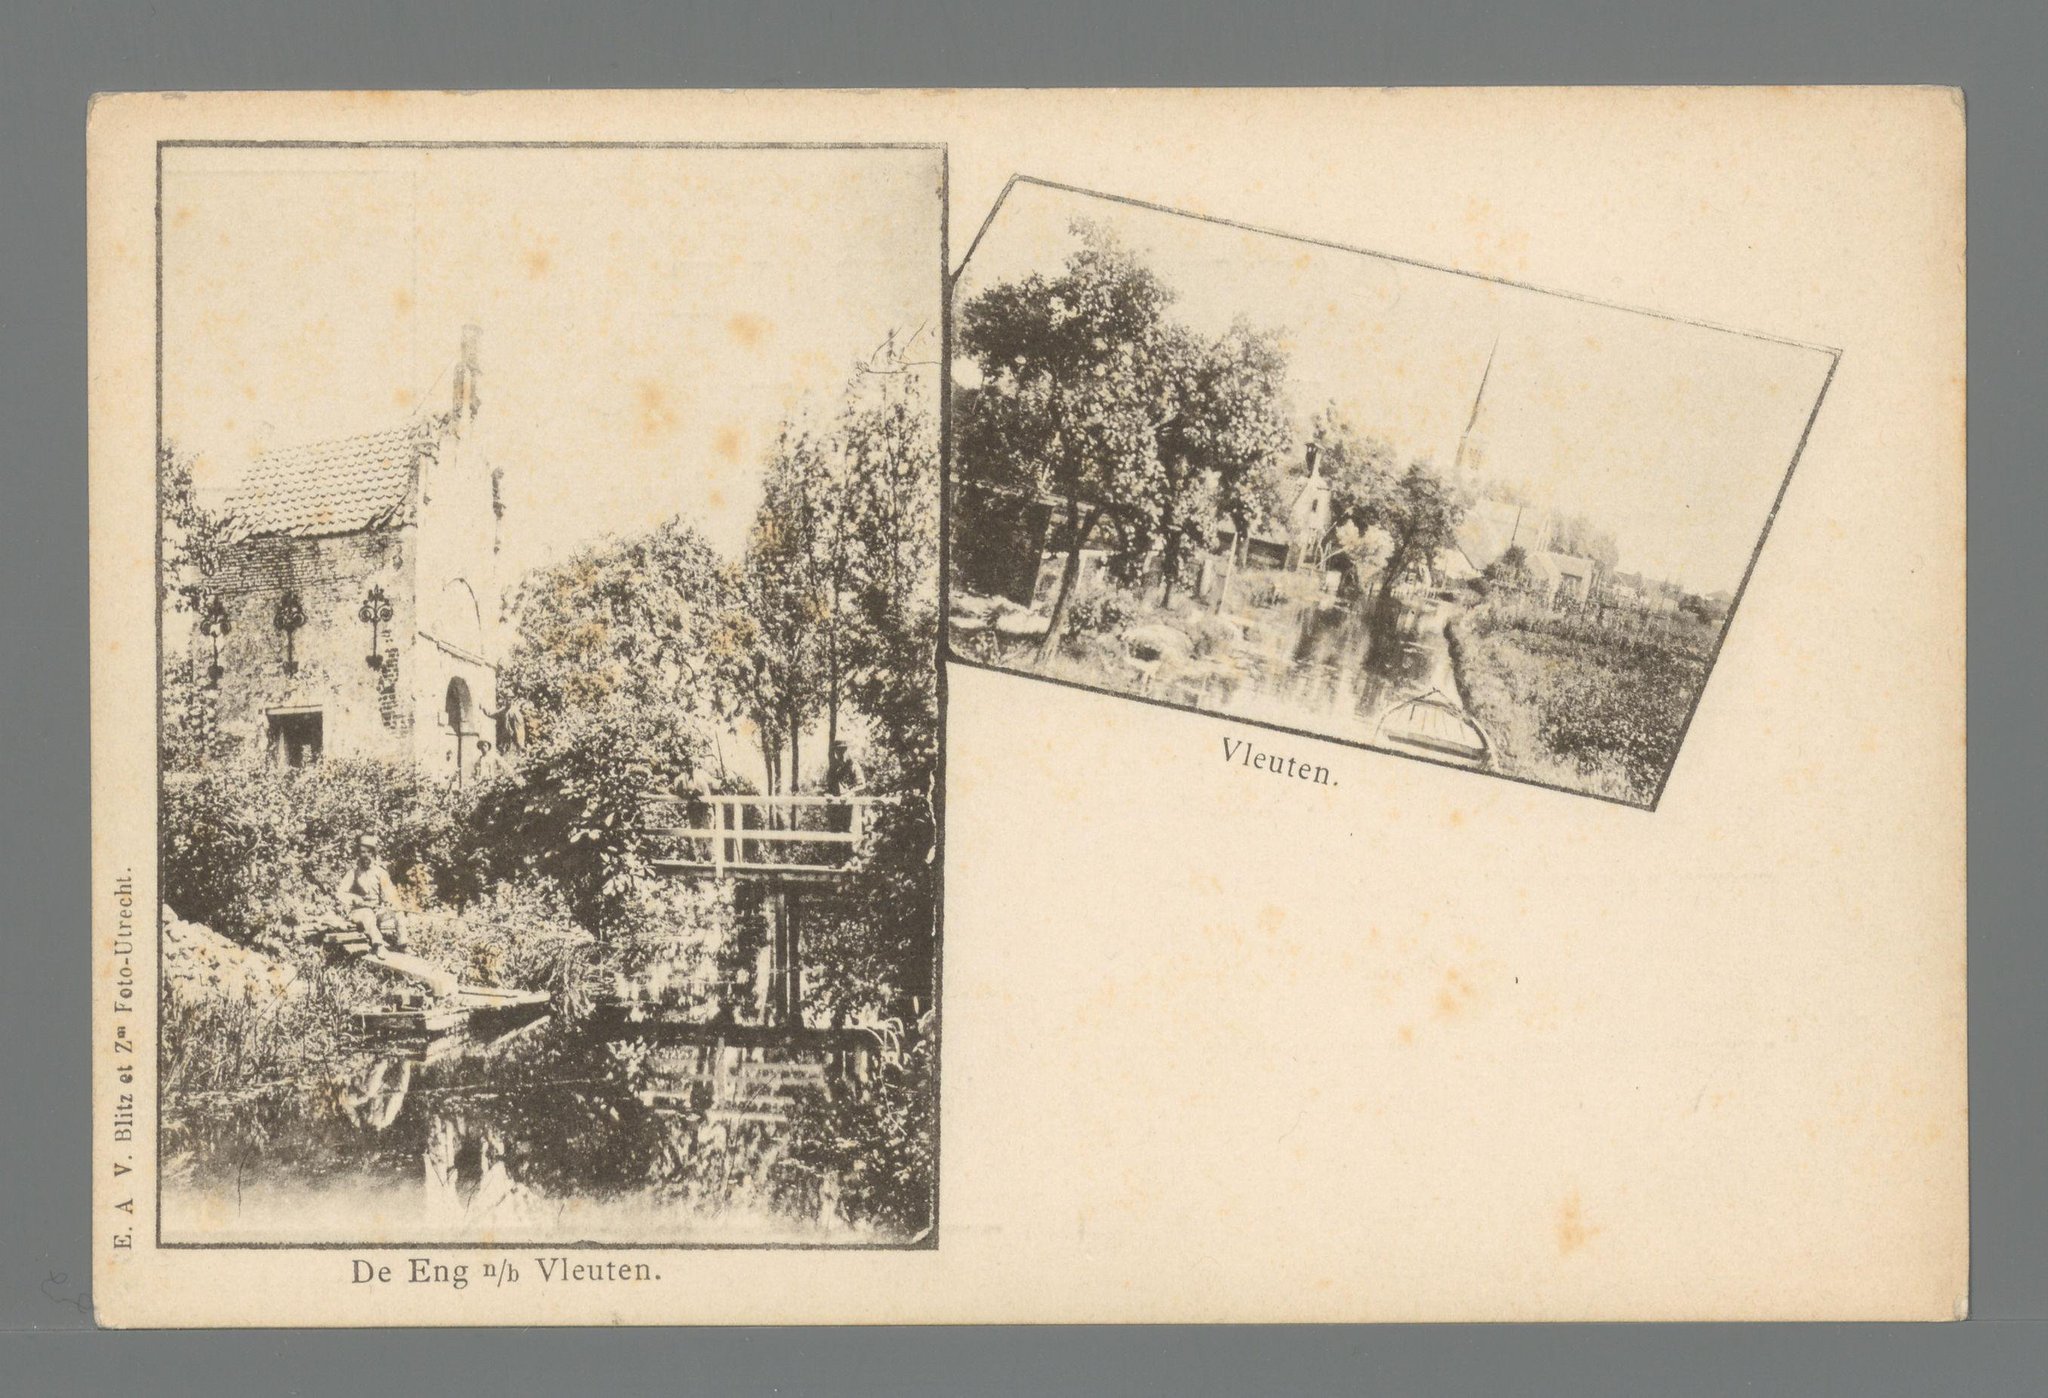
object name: ansichtkaart, prentbriefkaart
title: De Eng n/b Vleuten. Vleuten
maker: Anonymous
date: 1892-1900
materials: cardboard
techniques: photograph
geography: vleuten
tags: city-view, and landscape with man-made constructions, castle